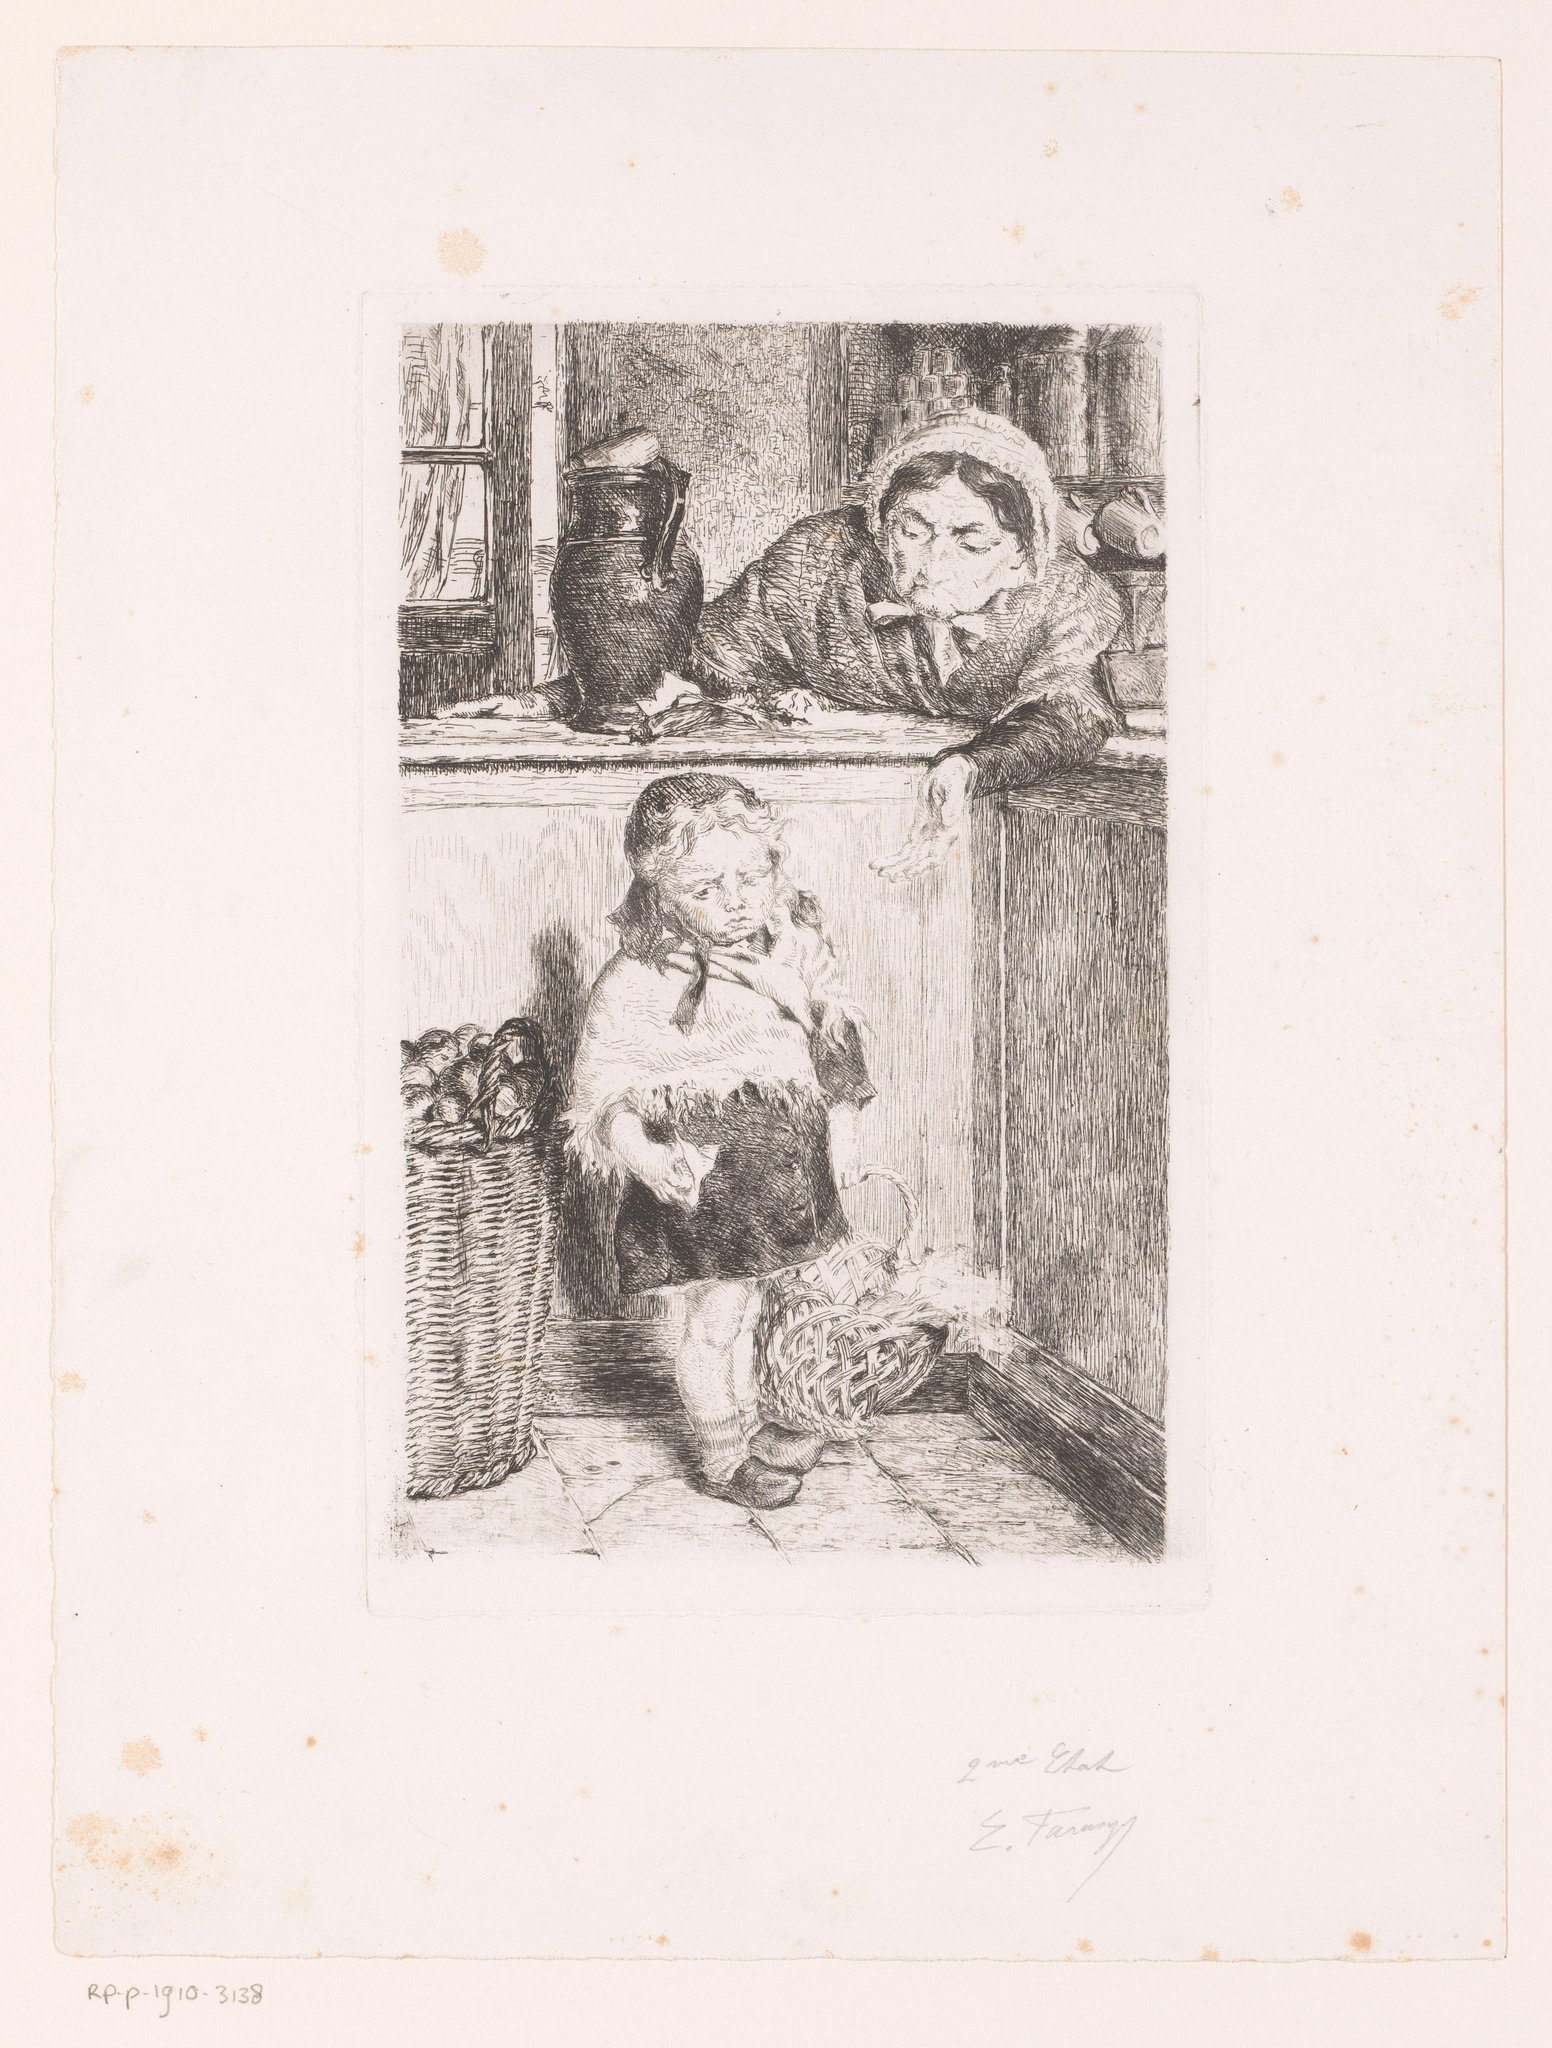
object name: print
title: Kind met mand bij een toonbank waarachter een vrouw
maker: edgard farasyn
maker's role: print maker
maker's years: 1858-1938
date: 1868-1910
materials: paper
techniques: etching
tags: counter ~ shop, child, container made of plant material other than wood: basket, old woman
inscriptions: inscription: ‘2me Etat’, collector's mark: Lugt 2228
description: Het kind is bedroefd en voelt in de zakken omdat het onderweg het geld is verloren. De vrouw achter de toonbank steekt haar hand uit om af te rekenen.